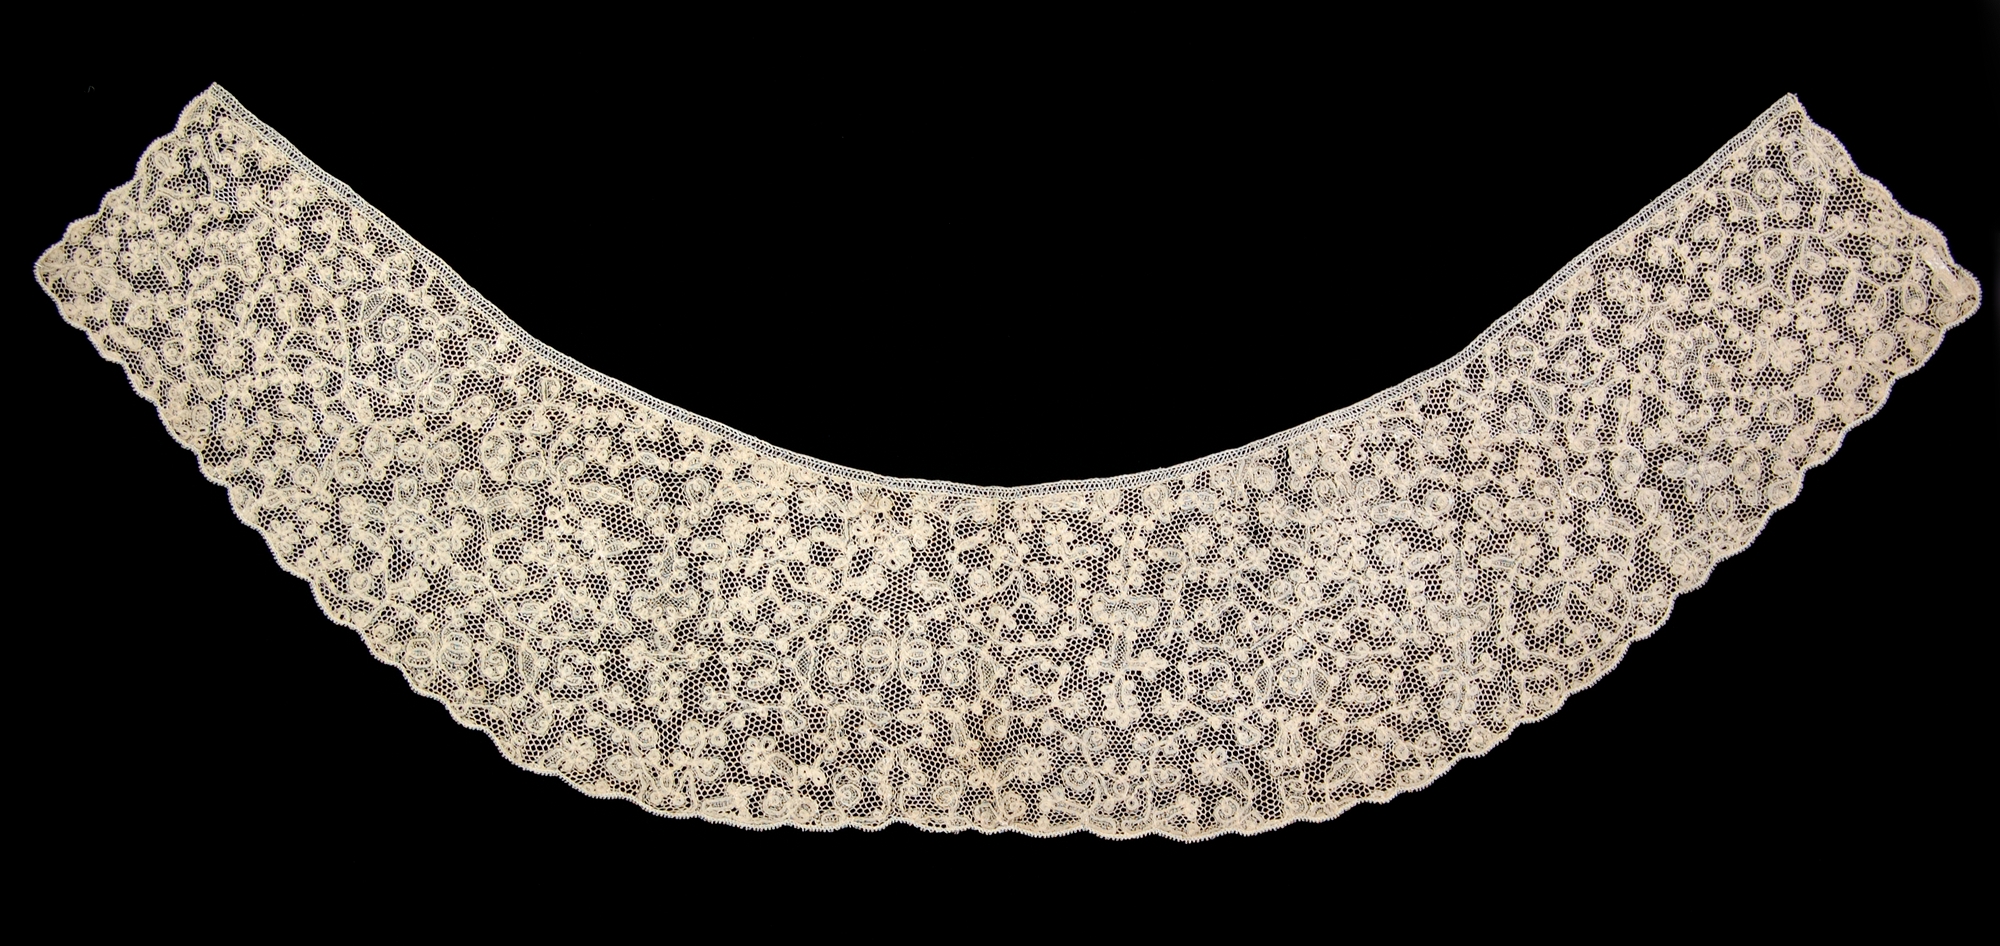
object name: collar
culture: italian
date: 1651-1675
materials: linen